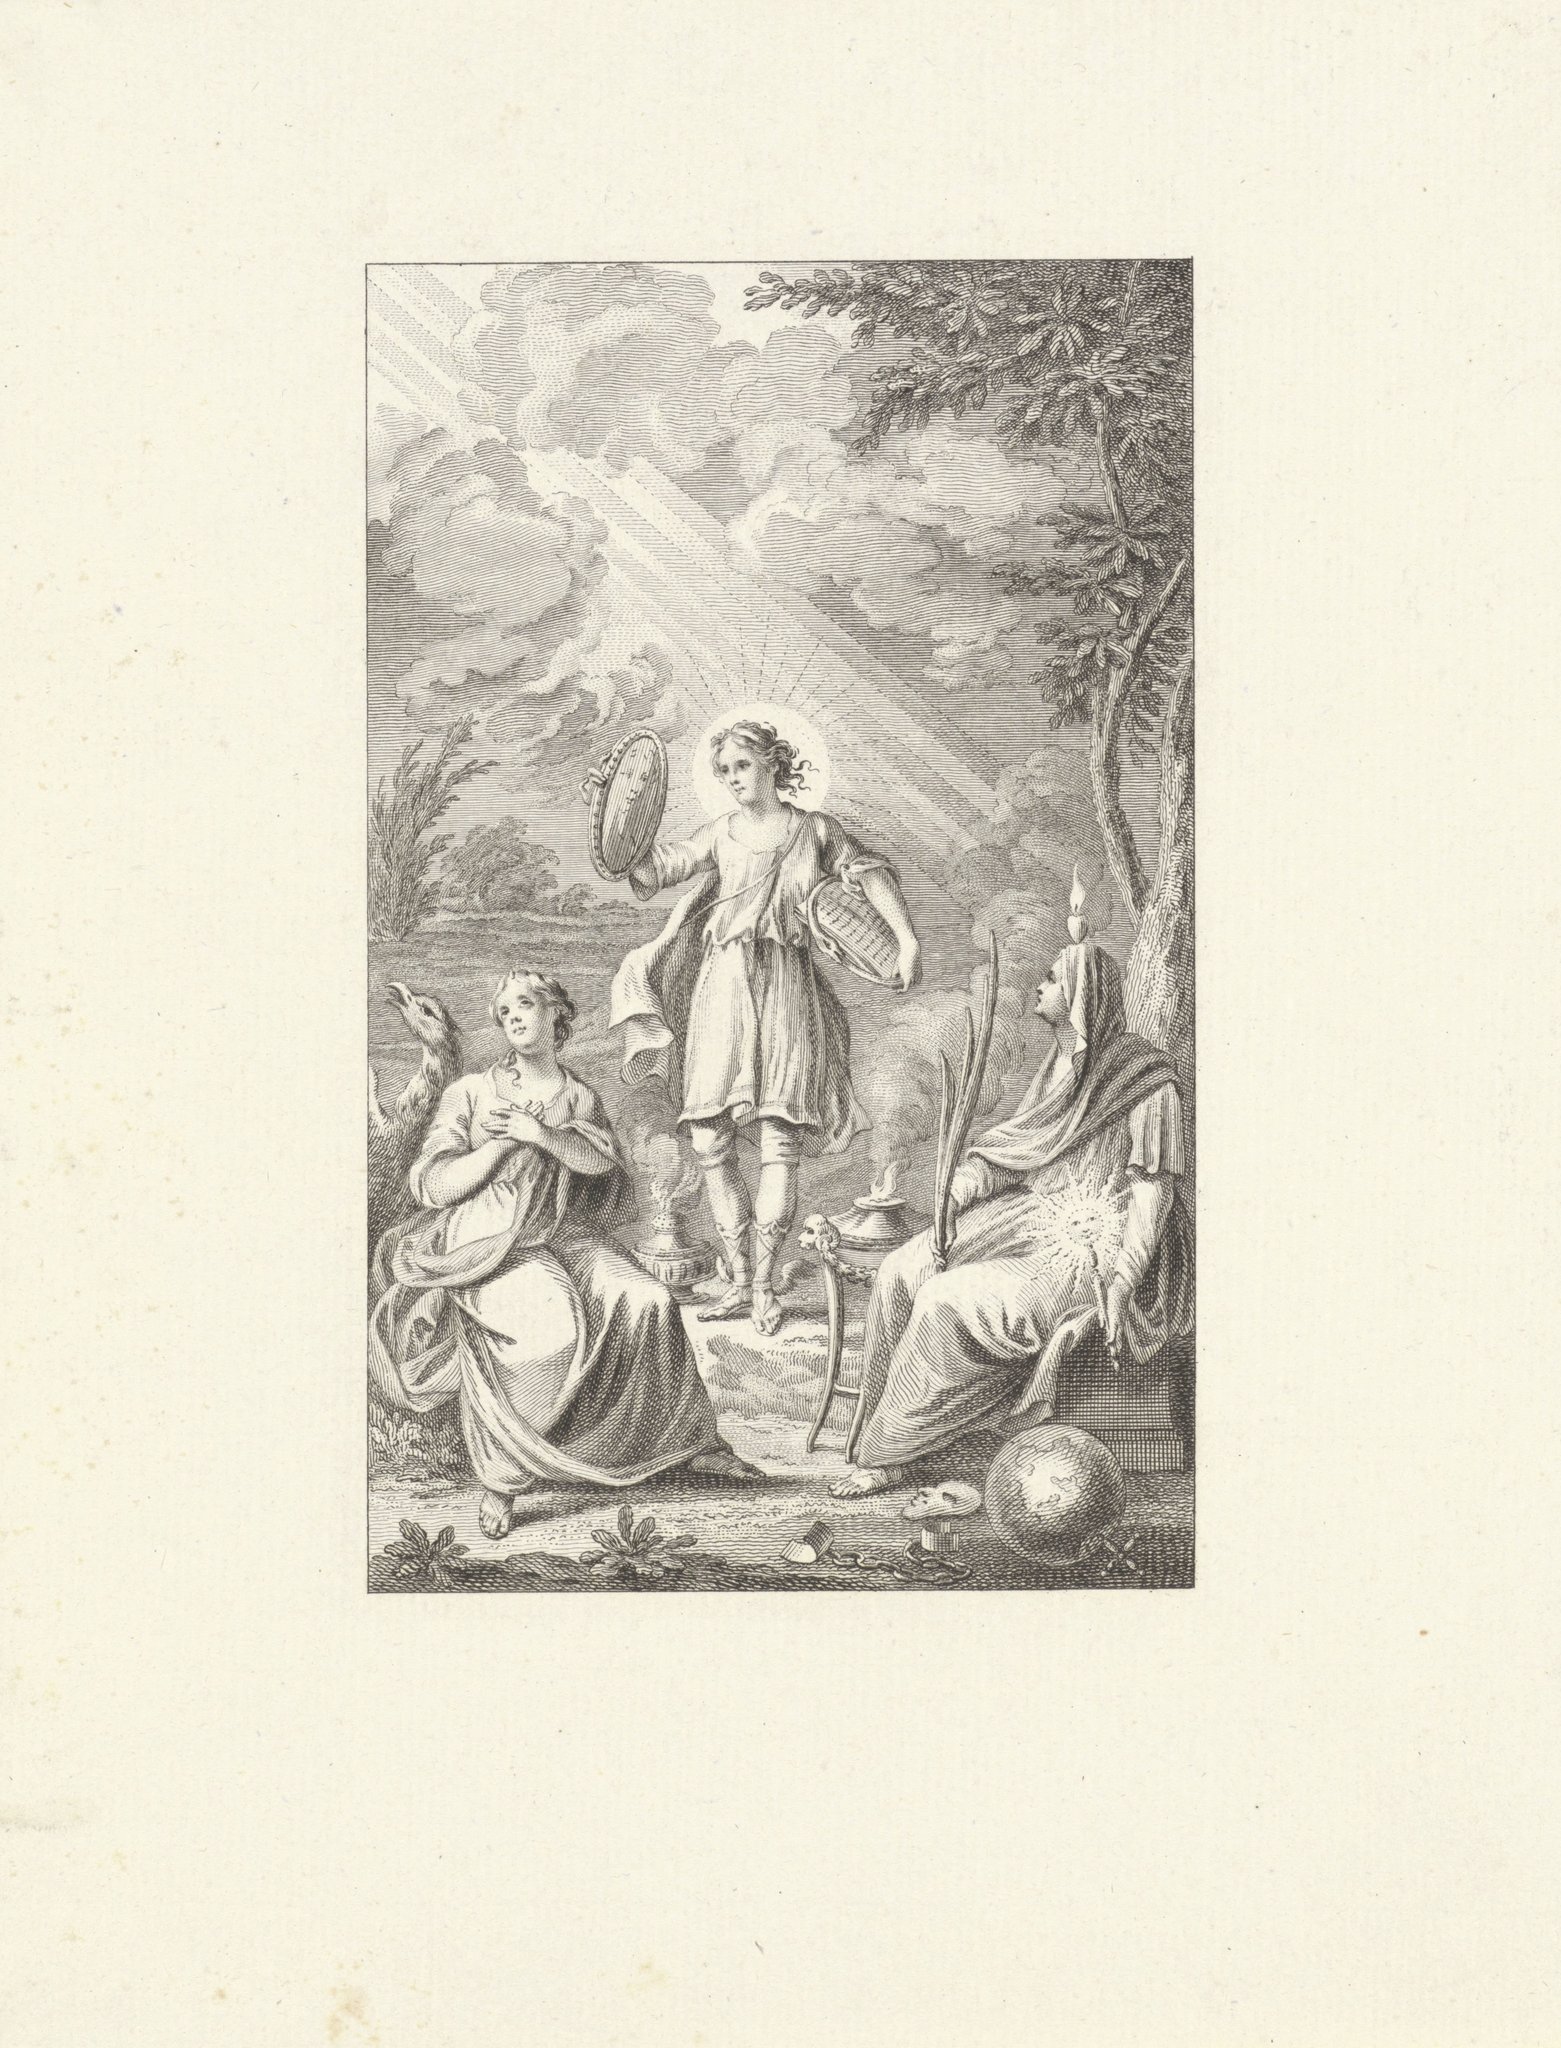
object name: print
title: Allegorie met twee personificaties en een jonge vrouw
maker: reinier vinkeles (i)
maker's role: draughtsman, print maker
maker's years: 1741-1816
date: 1751-1816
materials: paper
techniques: engraving, etching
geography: amsterdam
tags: fides (faith) as roman personification, mirror, prudentia (prudence) as roman personification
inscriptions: collector's mark: Lugt 240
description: Allegorische voorstelling met de personificatie van Voorzichtigheid met een slang en een spiegel en de personificatie van het Ware Geloof met op het hoofd een brandend hart. Zij worden vergezeld door een jonge vrouw.